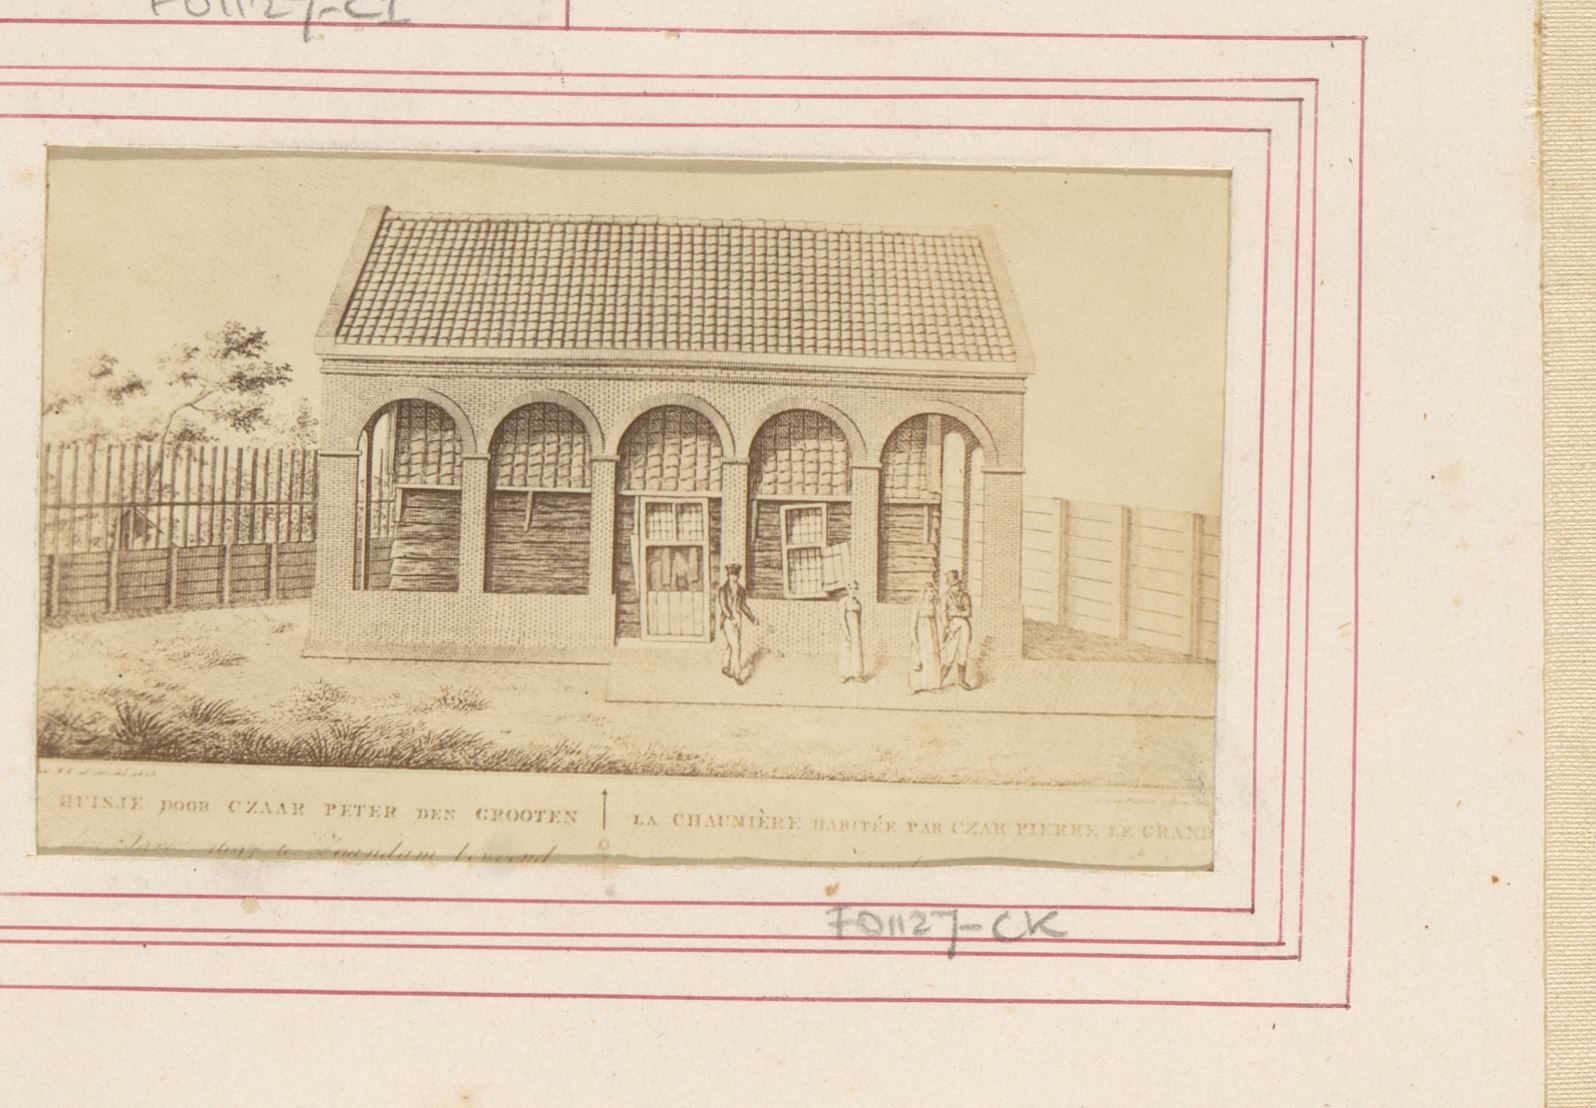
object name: photograph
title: Fotoreproductie van (vermoedelijk) een prent met onderschrift, voorstellend het exterieur van het Tsaar Peterhuisje in Zaandam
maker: Anonymous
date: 1865-1875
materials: photographic support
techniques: albumen print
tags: rural housing, e.g. country-house, villa, cottage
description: Onderdeel van Album met foto's en litho's van bezienswaardigheden in Noord- en Zuid-Hollandse steden, schilderijen en klederdrachten.